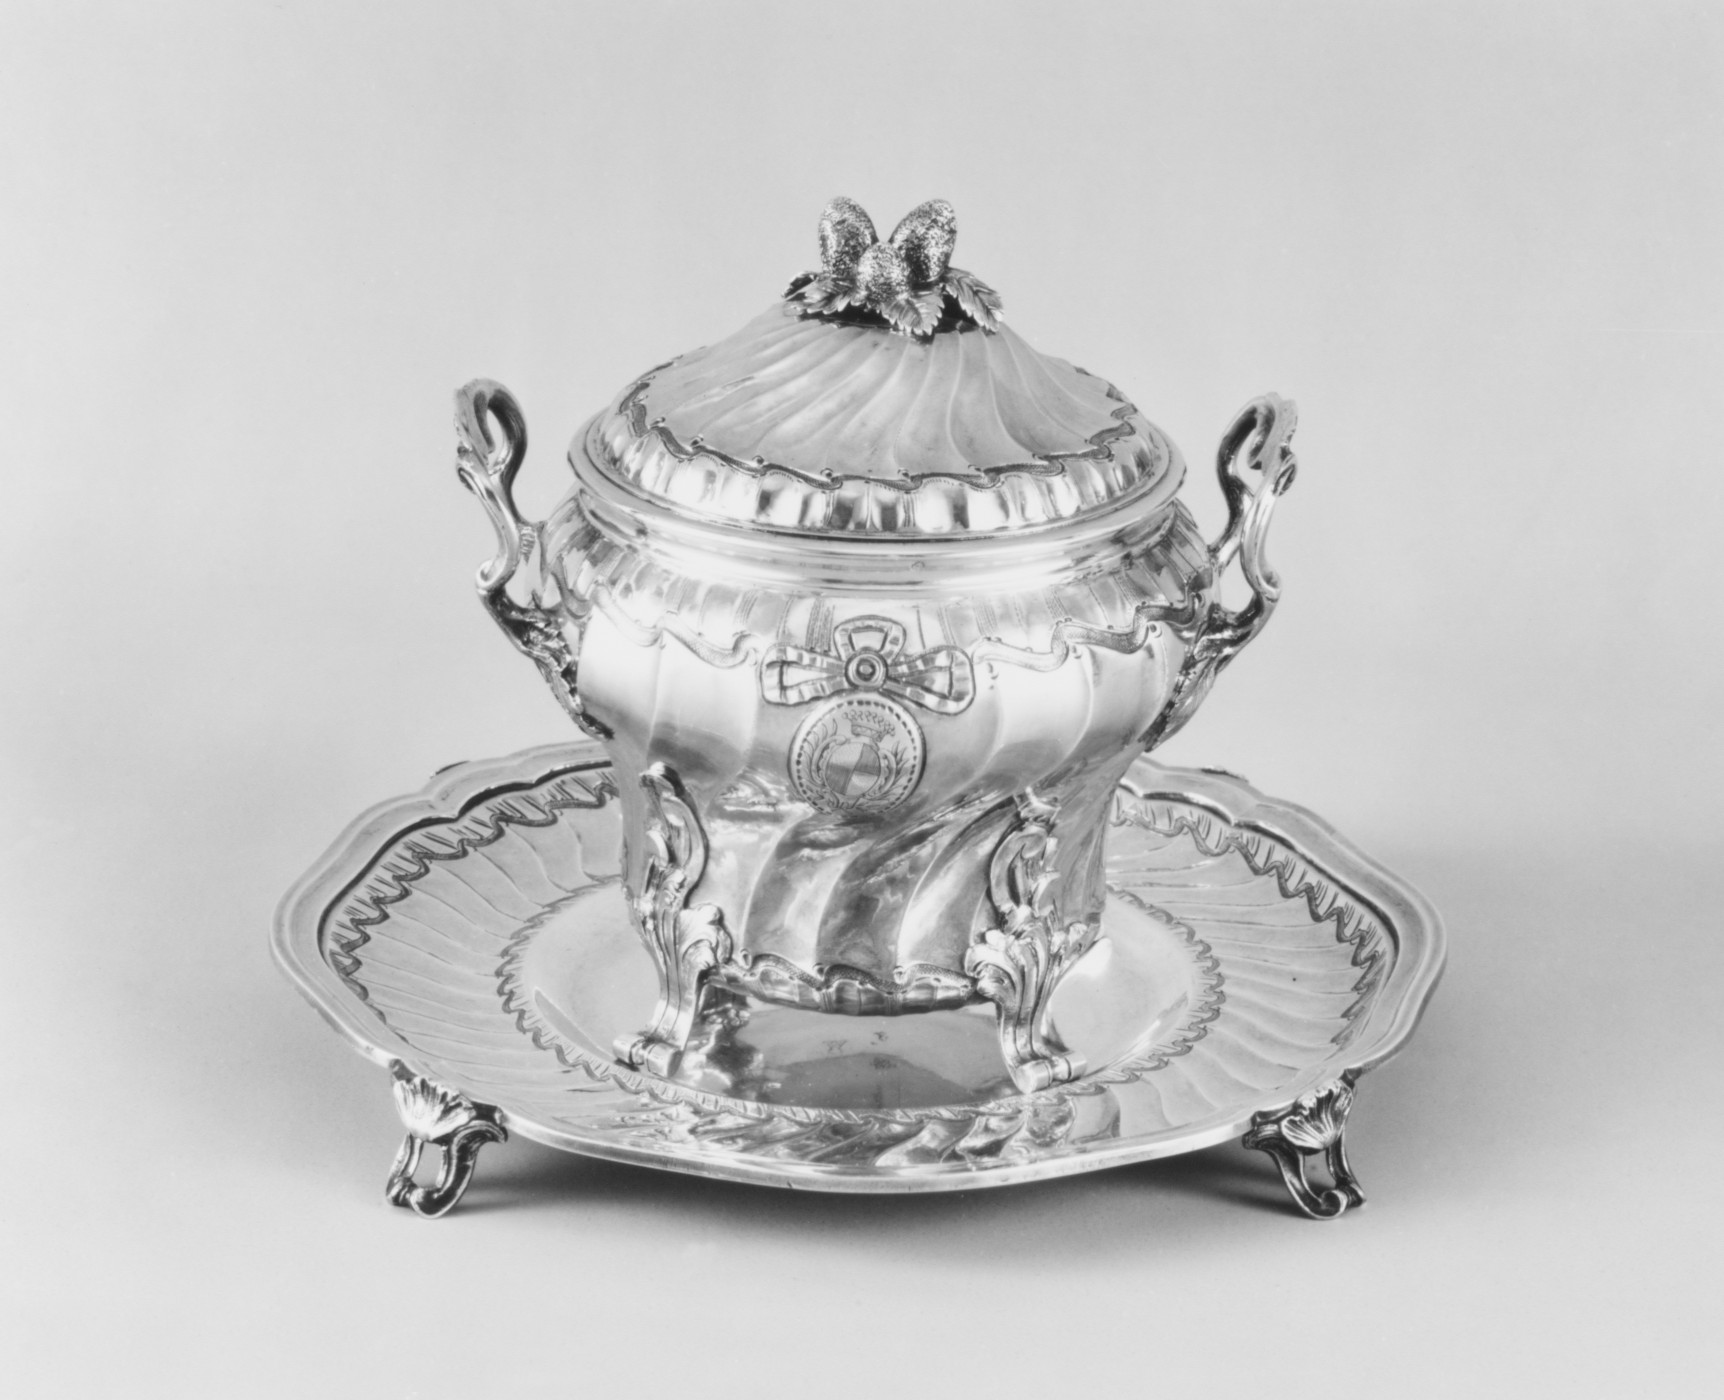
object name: sugar bowl with cover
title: Sugar bowl with cover and tray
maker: alexandre de roussy, the younger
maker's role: maker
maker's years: 1729-1829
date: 1777-1778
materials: silver